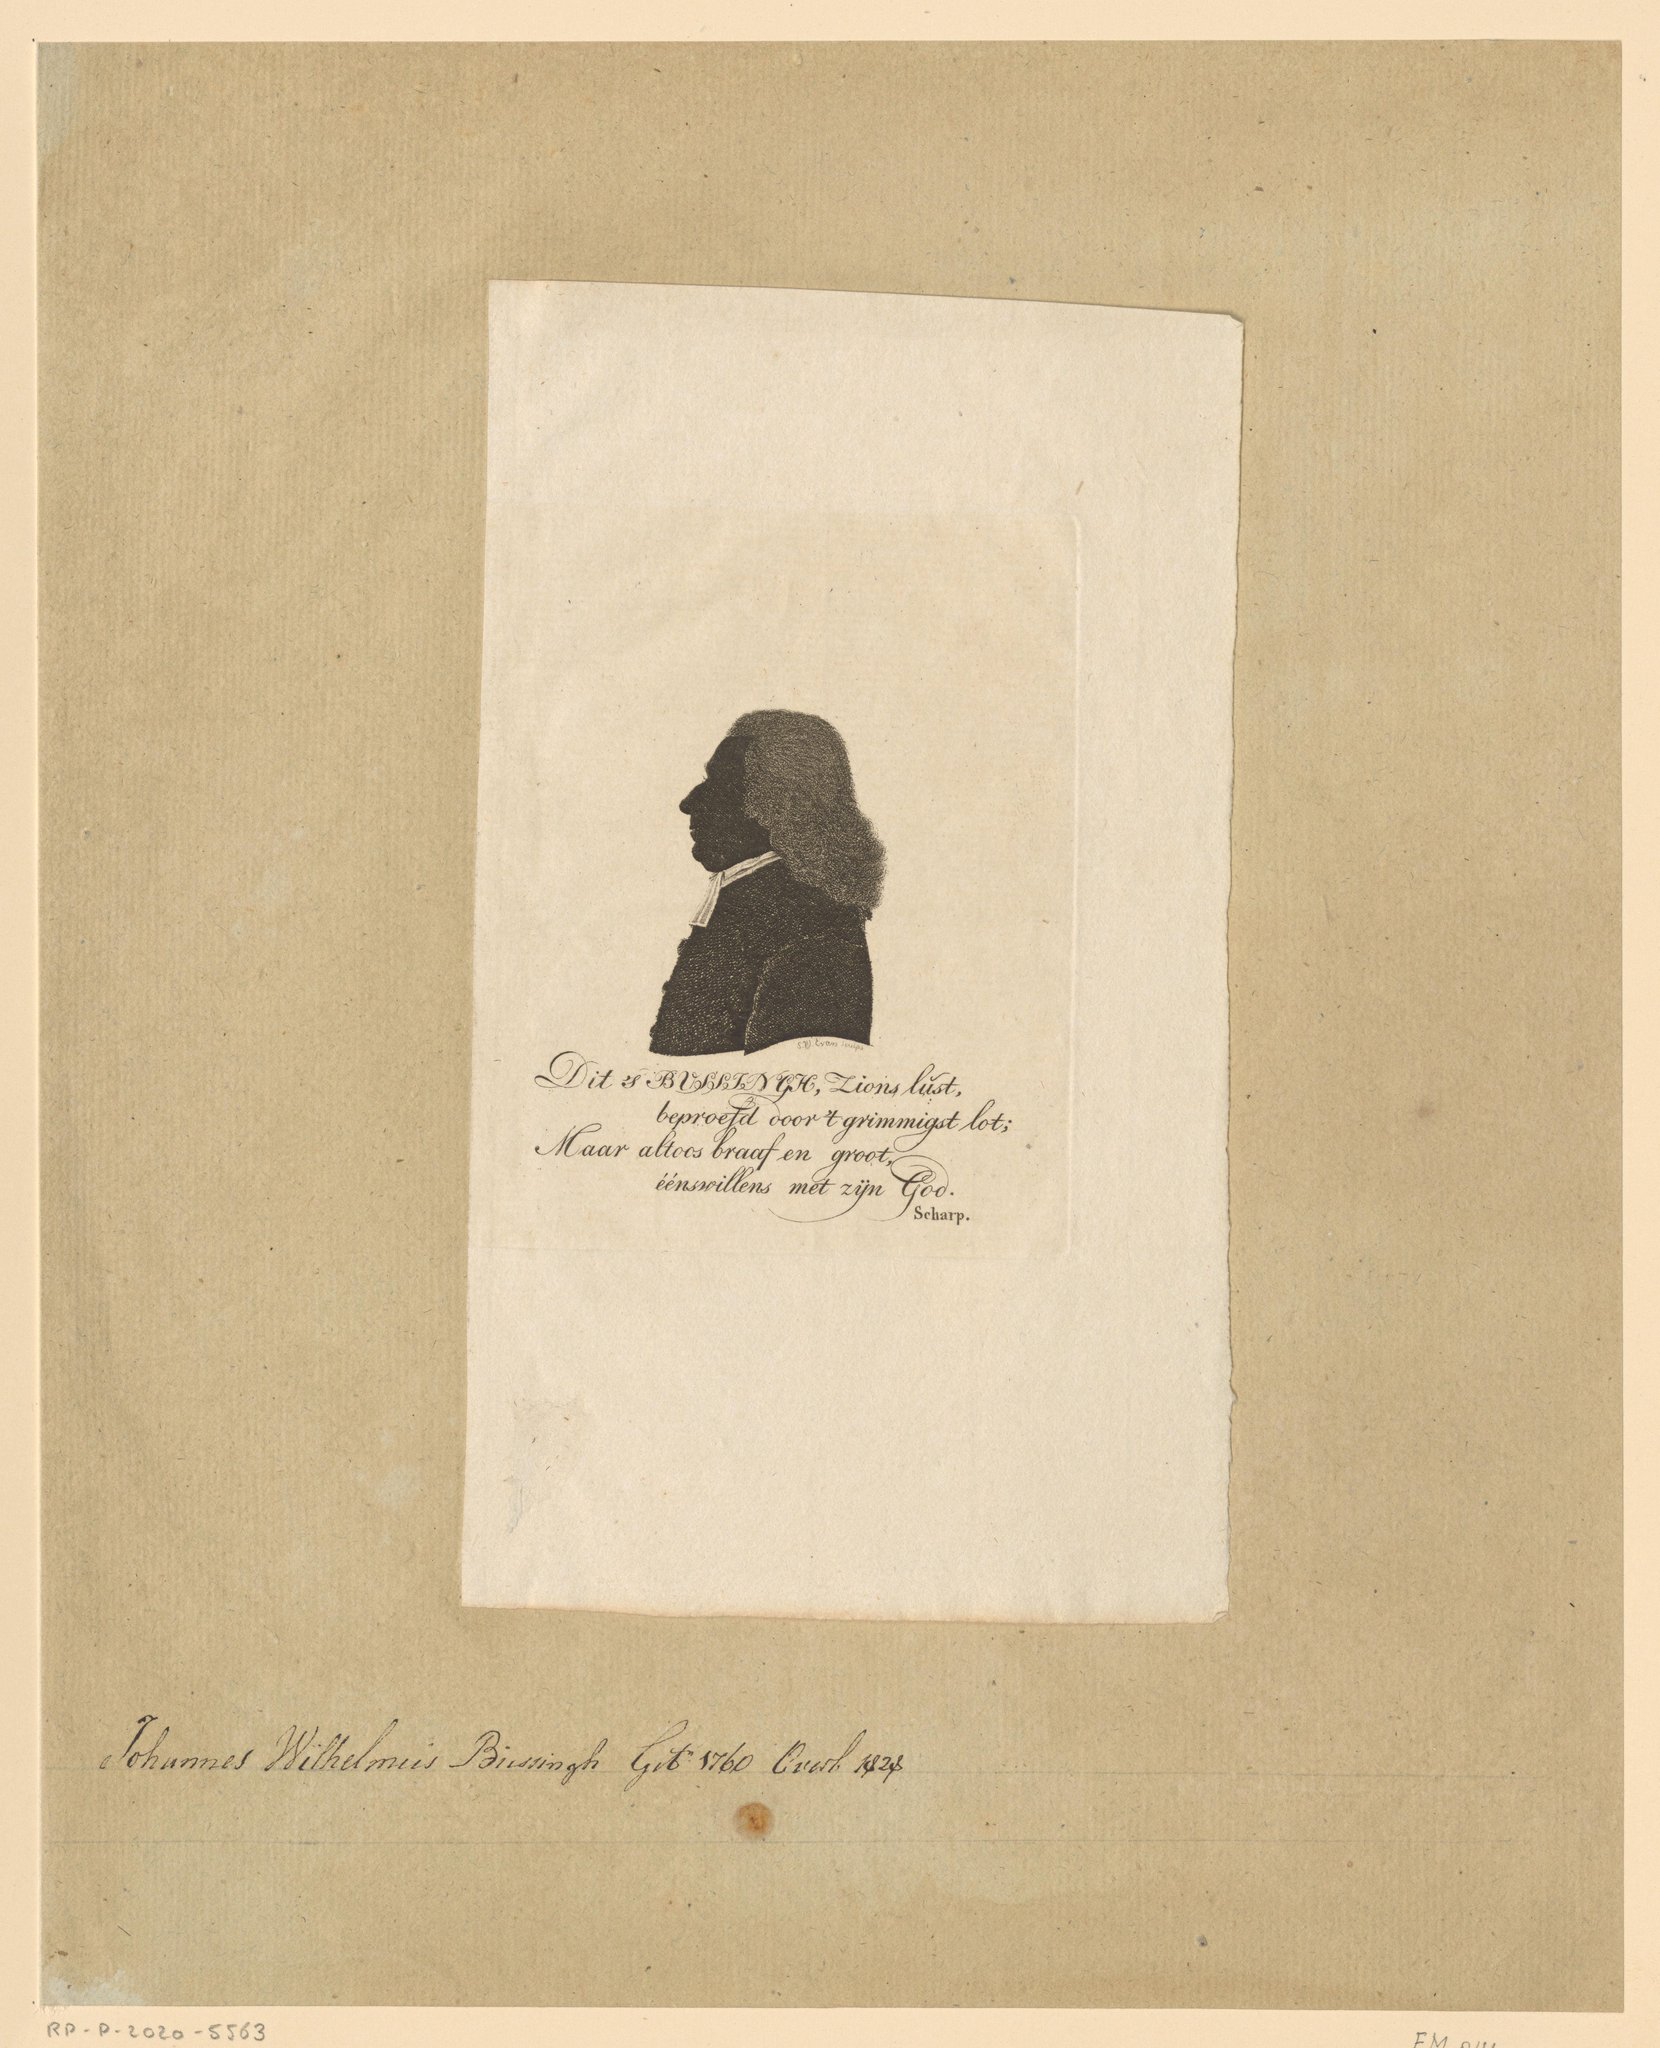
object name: print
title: Silhouetportret van Johannes Wilhelmus Bussingh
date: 1782-1816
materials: paper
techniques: engraving, etching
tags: johannes wilhelmus bussingh, historical persons, portrait of a writer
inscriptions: inscription: ‘Johannes Wilhemus Bussingh Geb 1760 Overl 1828’